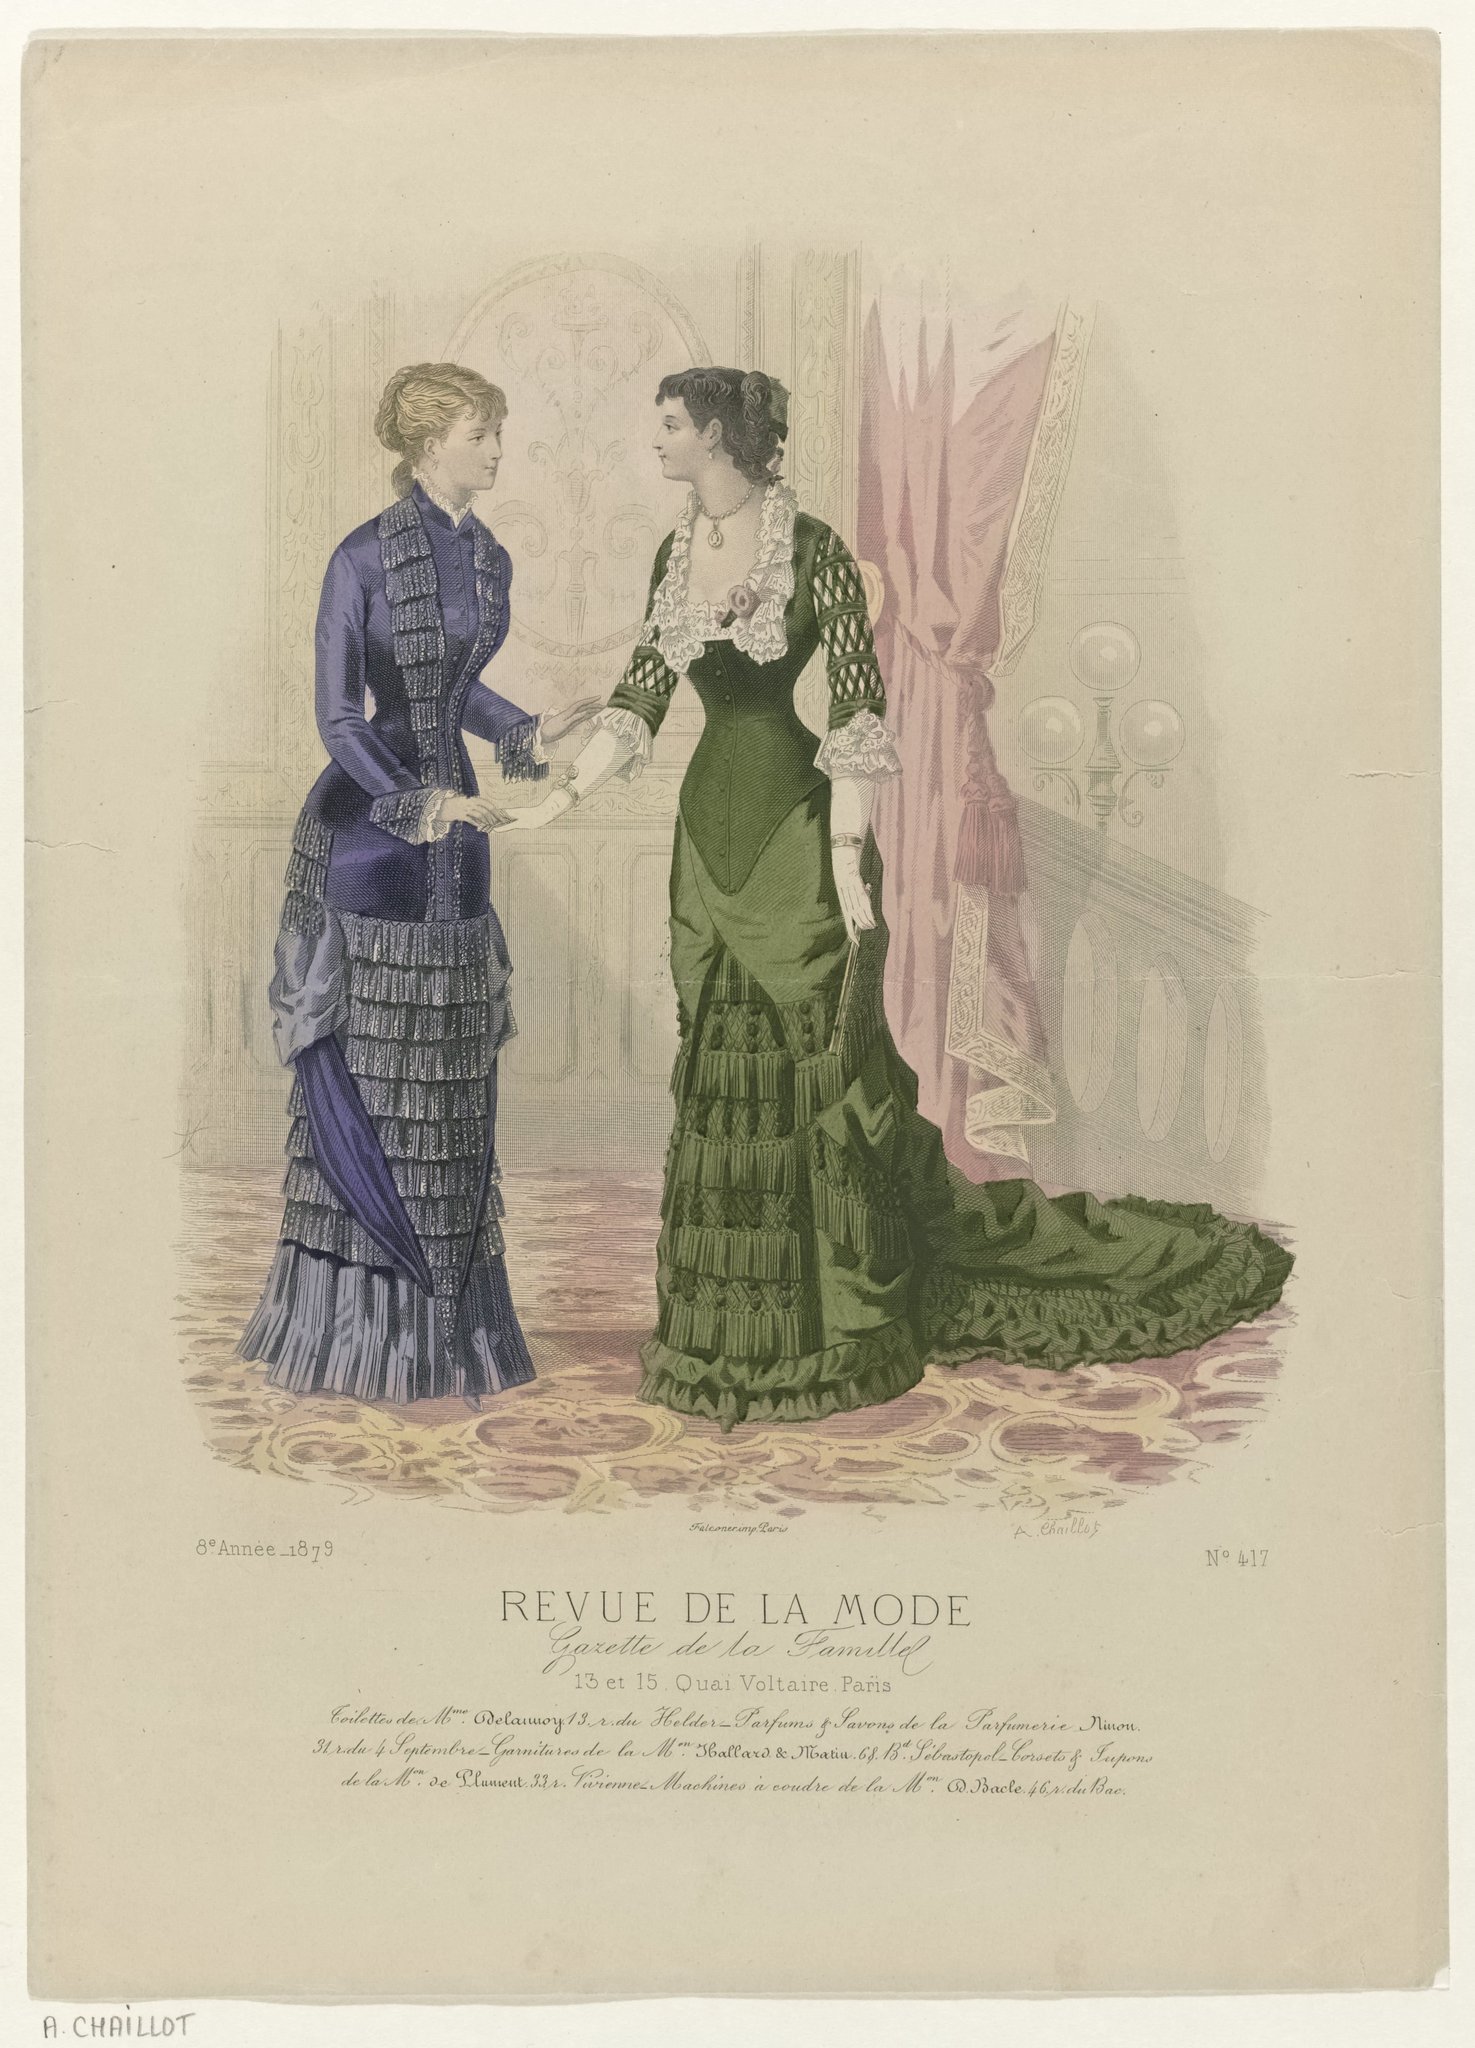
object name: fashion print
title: Revue de la Mode, Gazette de la Famille, 1879, 8e année, No. 417: Toilettes de Mme Delaunoy (...)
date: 1879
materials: paper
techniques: engraving, hand coloring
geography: paris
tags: corsage (+ women's clothes), dress, gown: evening dress (+ women's clothes), gloves, mittens (long gloves) (+ women's clothes), anklet (+ women's clothes), fashion plates, dress, gown (+ women's clothes), staircase, fan (+ women's clothes), bracelet, wristlet (+ women's clothes)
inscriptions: caption: ‘Toilettes de M.me Delaunoy, 13, r. du Helder_ Parfums & Savons de la Parfumerie Ninon 31, r. du 4 Septembre_ Garnitures de la M.on Hallard & Matin, 68. B.d Sébastopol_Corsets & Jupons de la M.on de Plument, 33, r. Vivienne_Machines à coudre de la M.on D. Bacle. 46. r. du Bac.’, title: ‘REVUE DE LA MODE / Gazette de la Famille’, address: ‘13 et 15, Quai Voltaire, Paris’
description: Twee vrouwen, gekleed in japonnen van Delaunoy. Rechts een avondjapon met halflange mouwen en sleep, Onderschrift met enkele regels reclametekst voor verschillende producten. Prent uit het modetijdschrift Revue de la Mode (1872-1913).